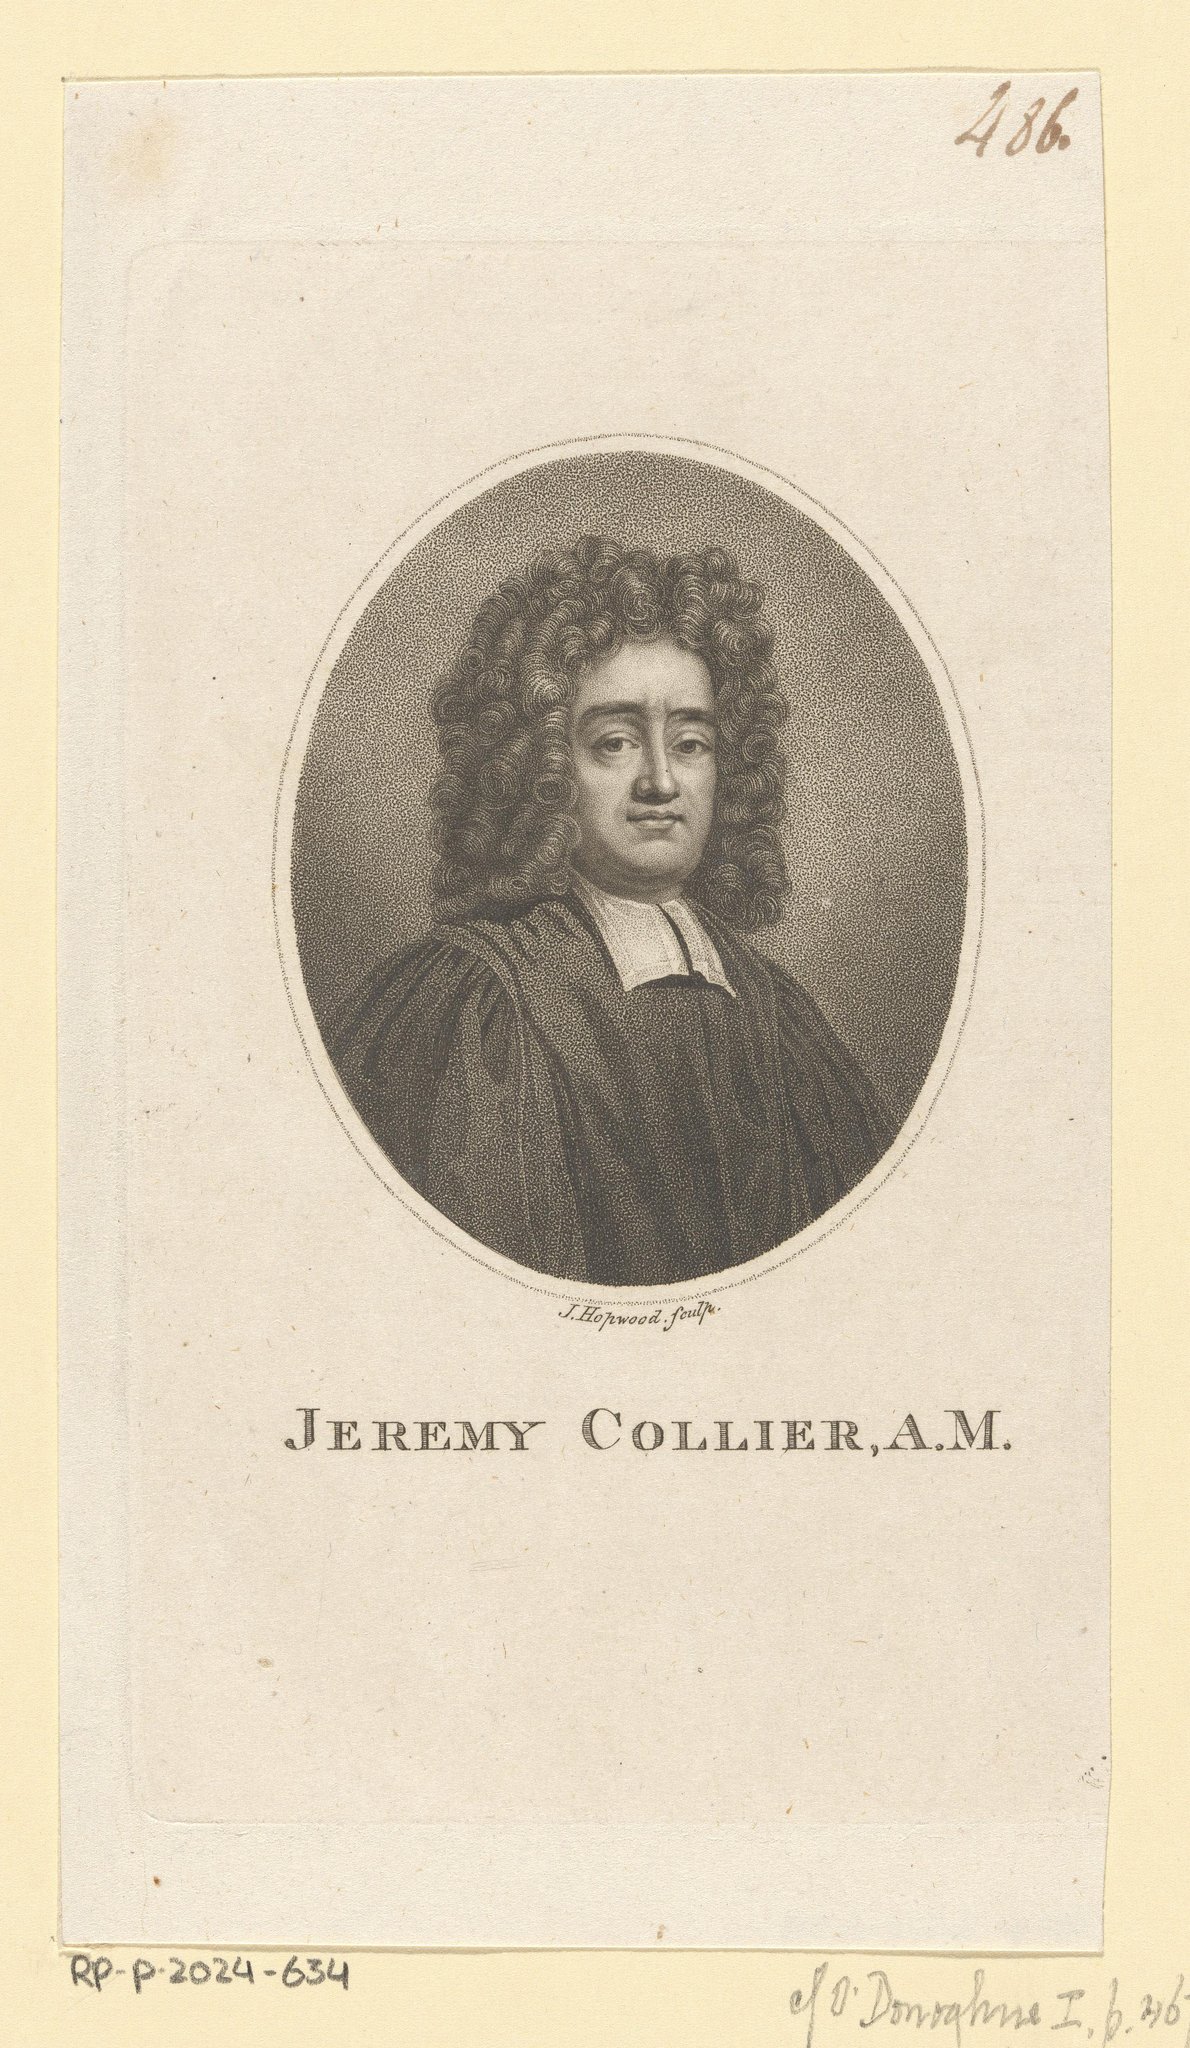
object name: print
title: Portret van Jeremy Collier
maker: james hopwood (i)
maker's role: print maker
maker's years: 1752-1819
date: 1801-1804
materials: paper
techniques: etching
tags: london, priest, theologian, historical persons, portrait of a writer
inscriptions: number: ‘486’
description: Prent waarschijnlijk uit: The Universal Magazine, april 1801.